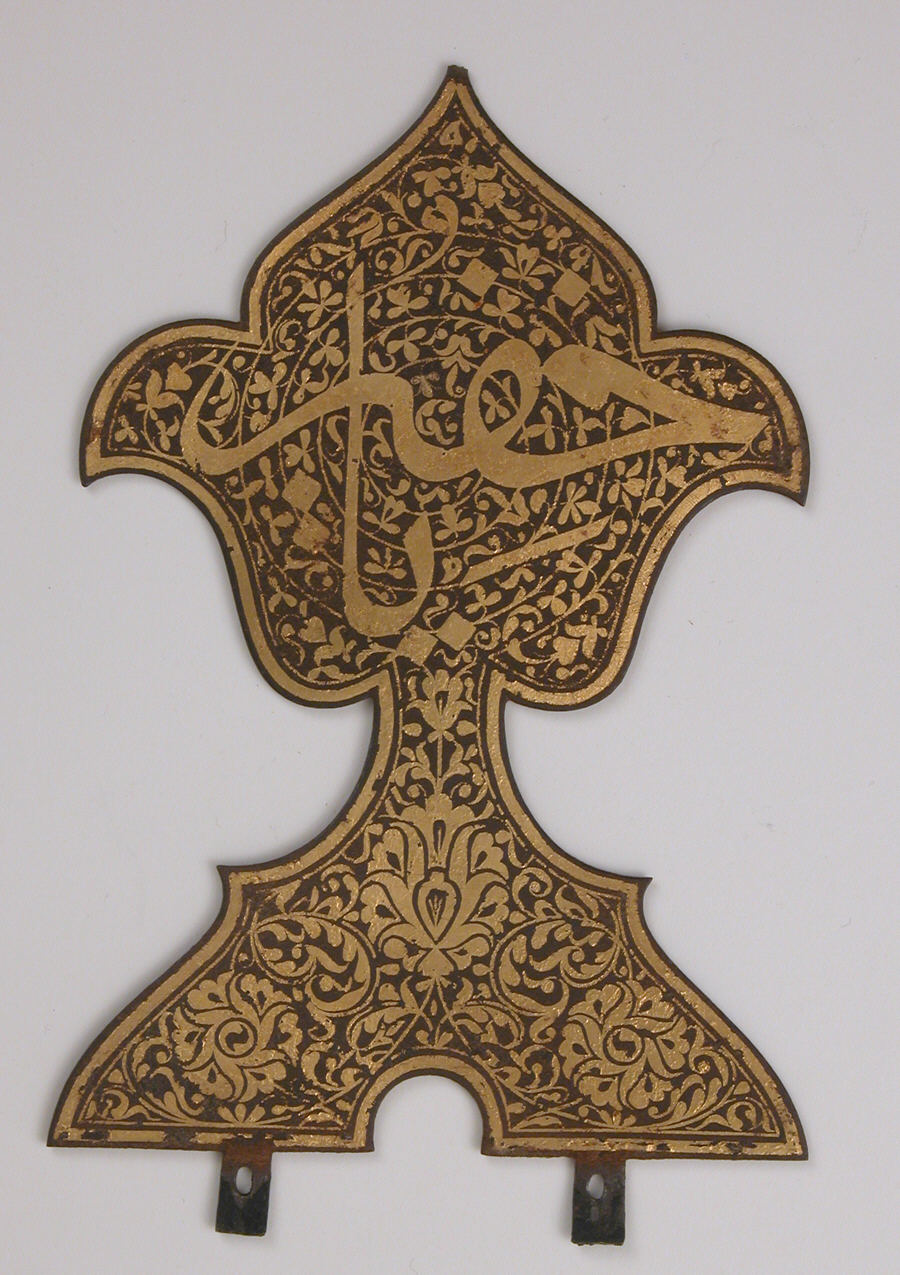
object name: finial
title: Finial with Inscription "Ya Khafar" ("Oh, Protector!")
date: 1601-1700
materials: foil, gold, silver, steel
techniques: inlay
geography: iran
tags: arabic,calligraphy